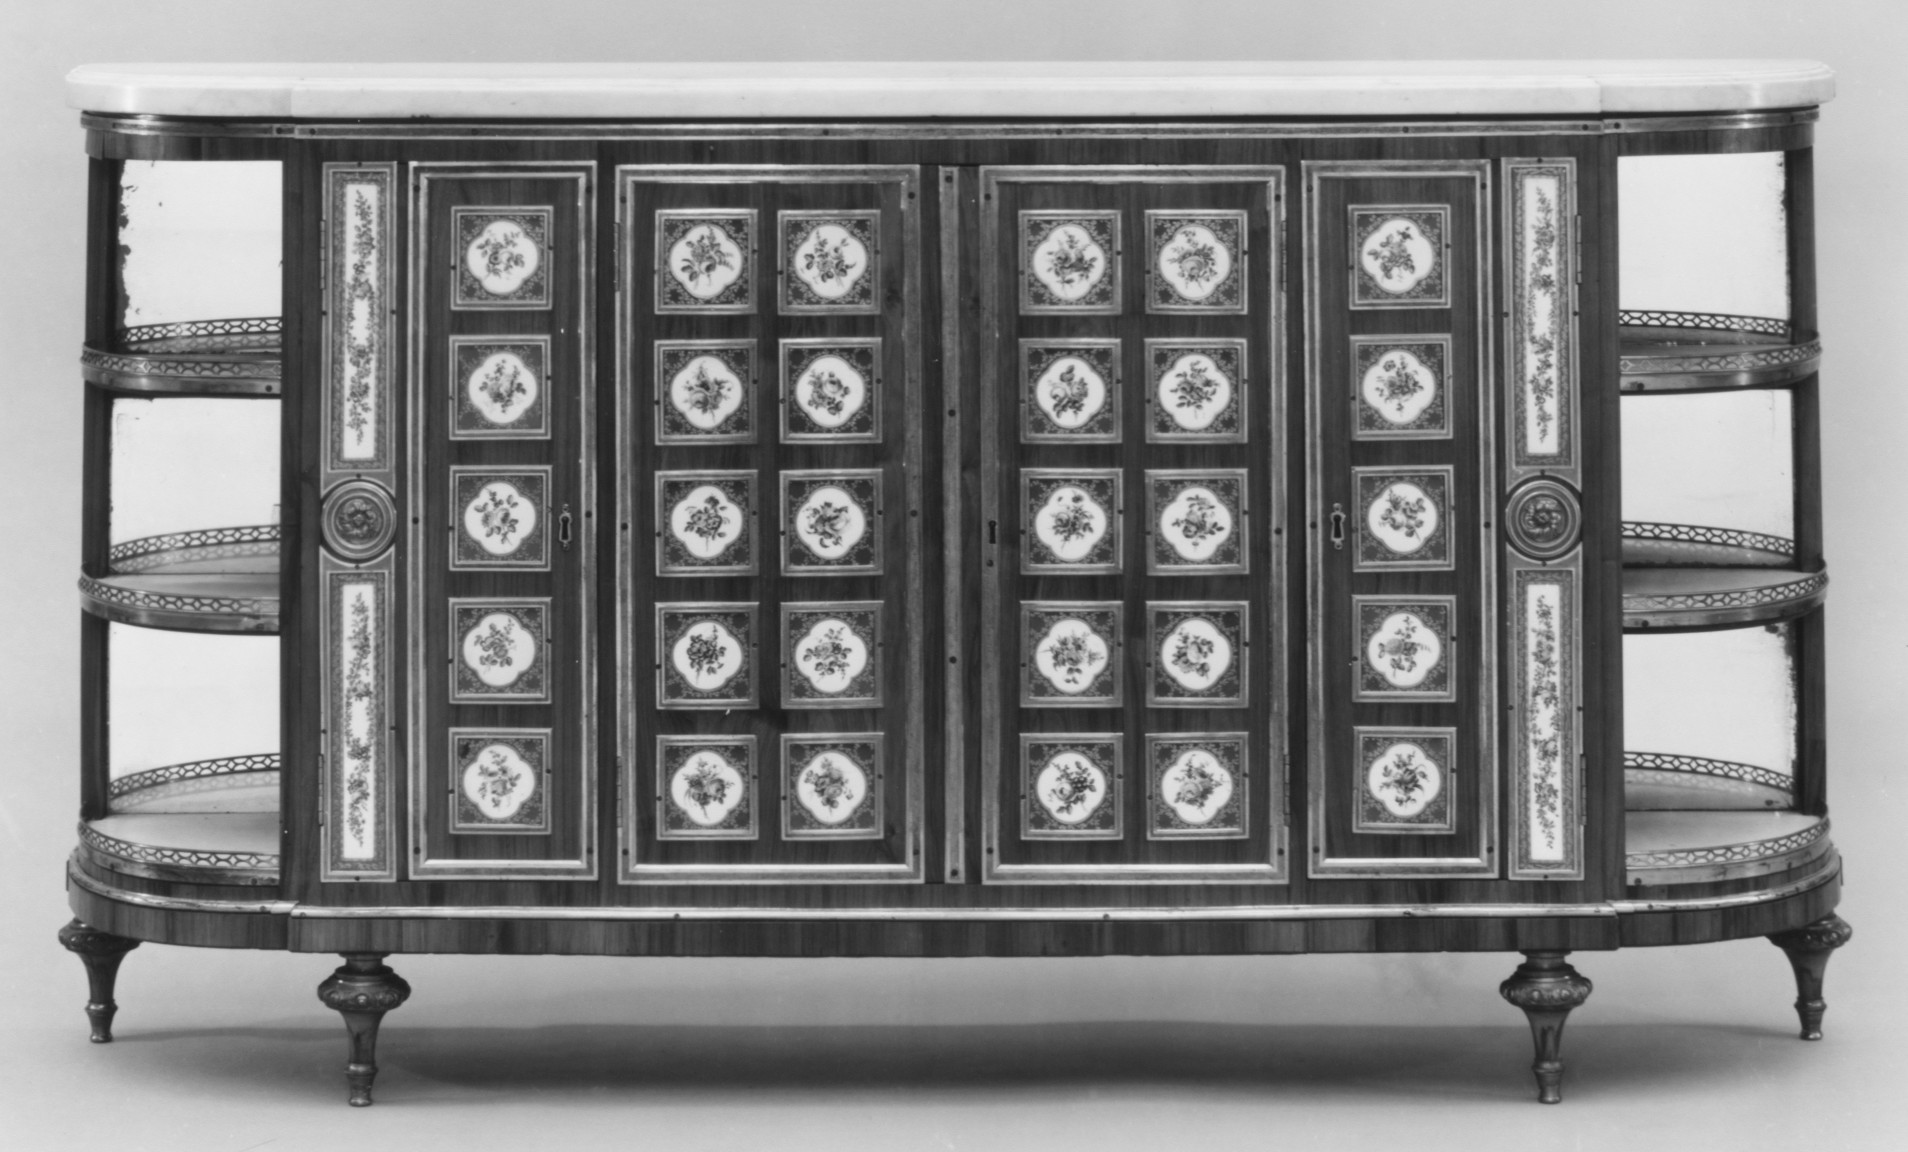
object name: cabinet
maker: sèvres manufactory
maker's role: manufactory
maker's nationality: french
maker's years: 1740-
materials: gilt bronze, glass, marble, wood, soft paste porcelain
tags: flowers